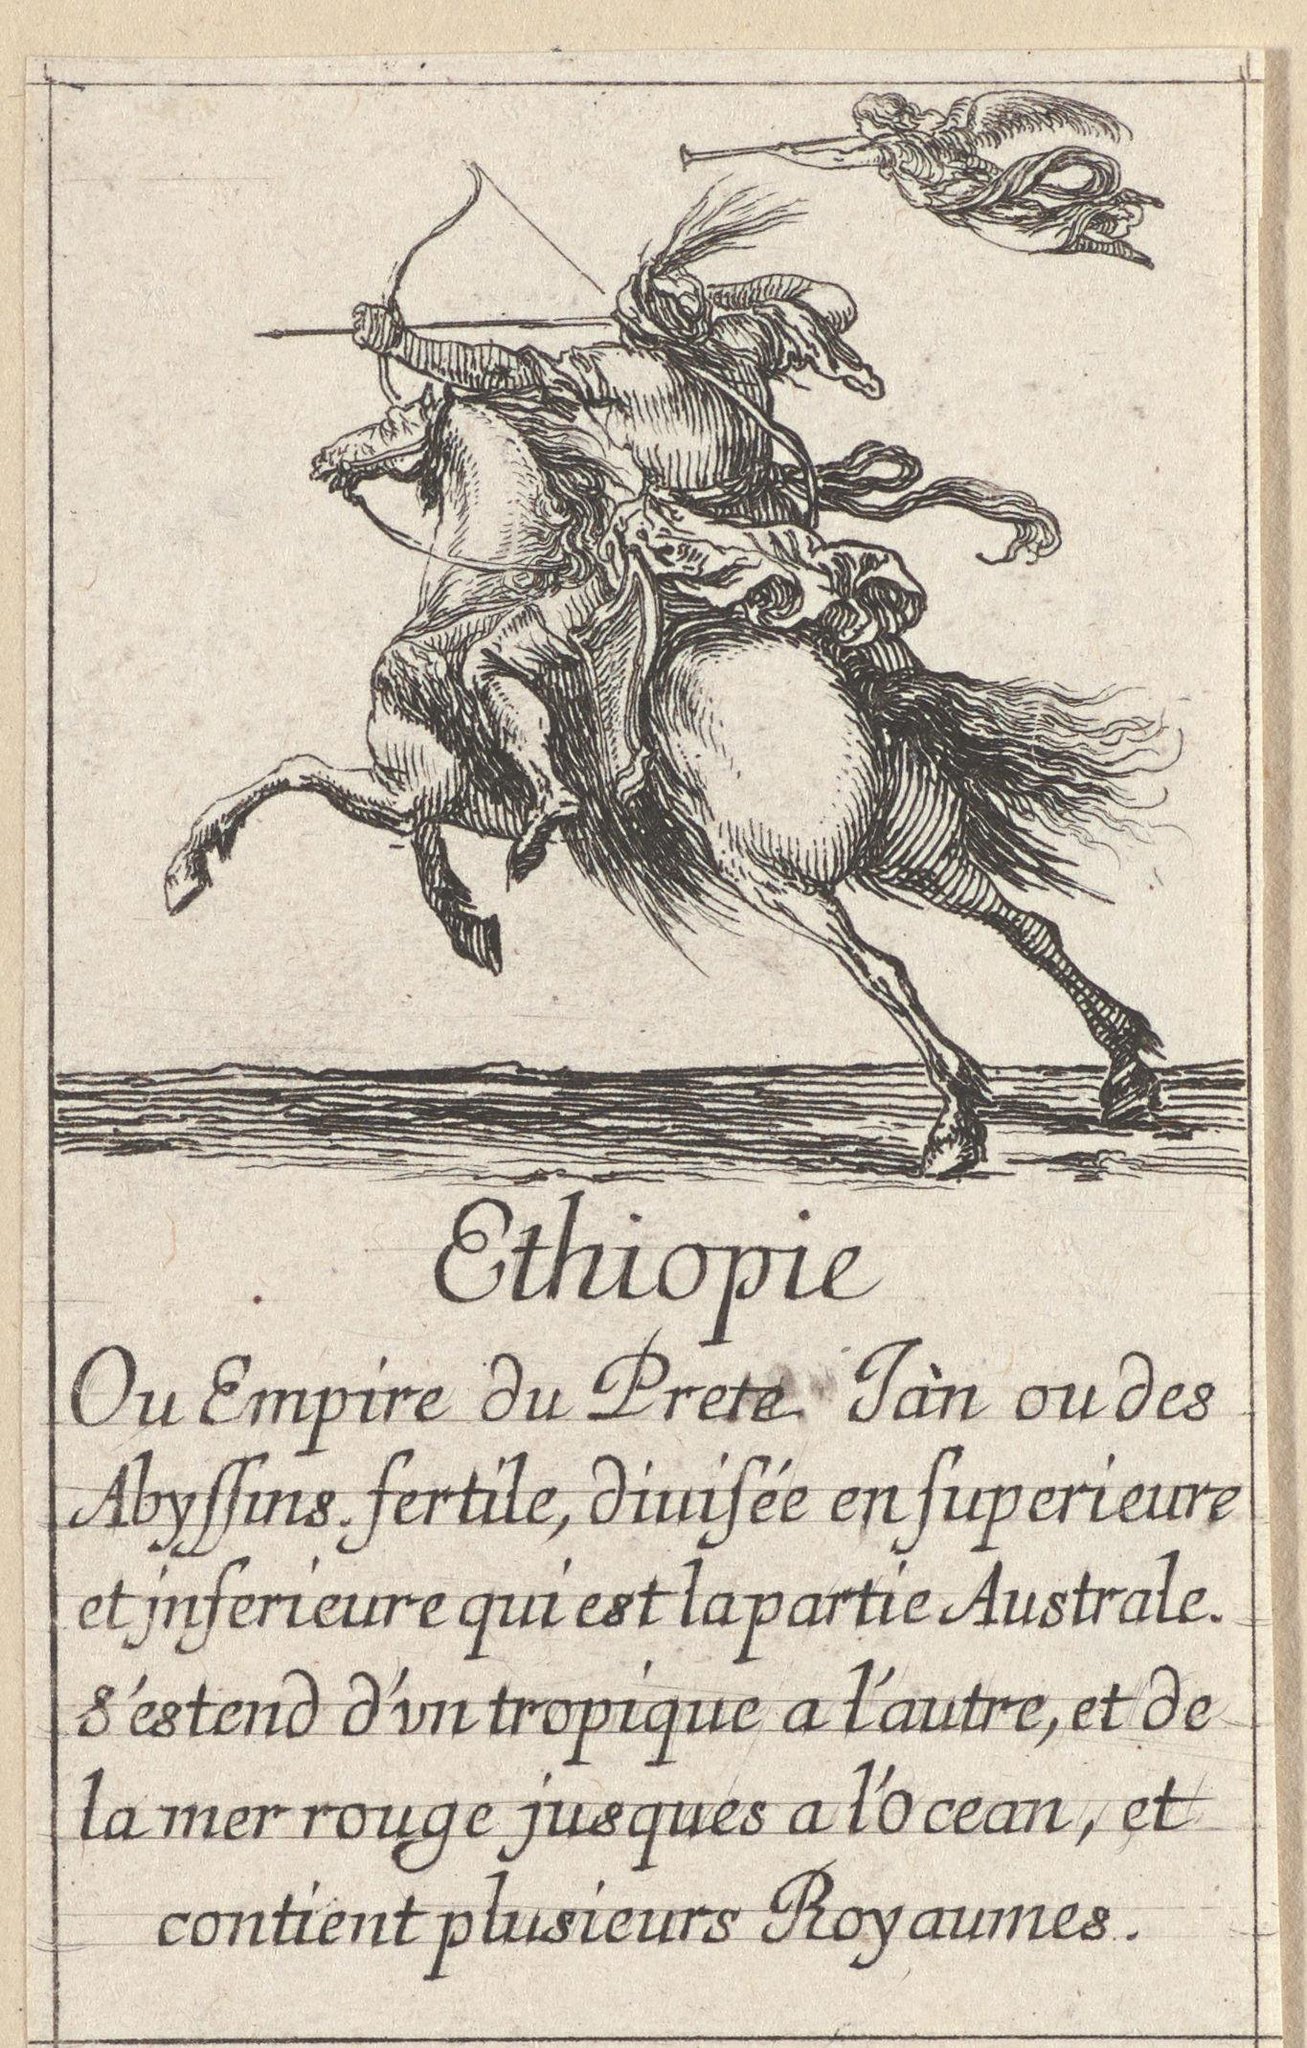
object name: print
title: Ethiopie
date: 1620-1664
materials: paper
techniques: etching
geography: paris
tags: riding a horse, ass, or mule; rider, horseman, africans (+ costume), horse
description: Deze prent maakt deel uit van een kaartspel met 52 kaarten met voorstellingen van vrouwen uit landen over de hele wereld. De serie is uitgedacht door Jean Desmarests de Saint-Sorlin in opdracht van Kardinaal Mazarin. Het kaartspel werd gemaakt voor de jonge Lodewijk XIV, samen met het Jeu des Fables, Jeu des Reynes Renommées en Jeu des Rois de France.